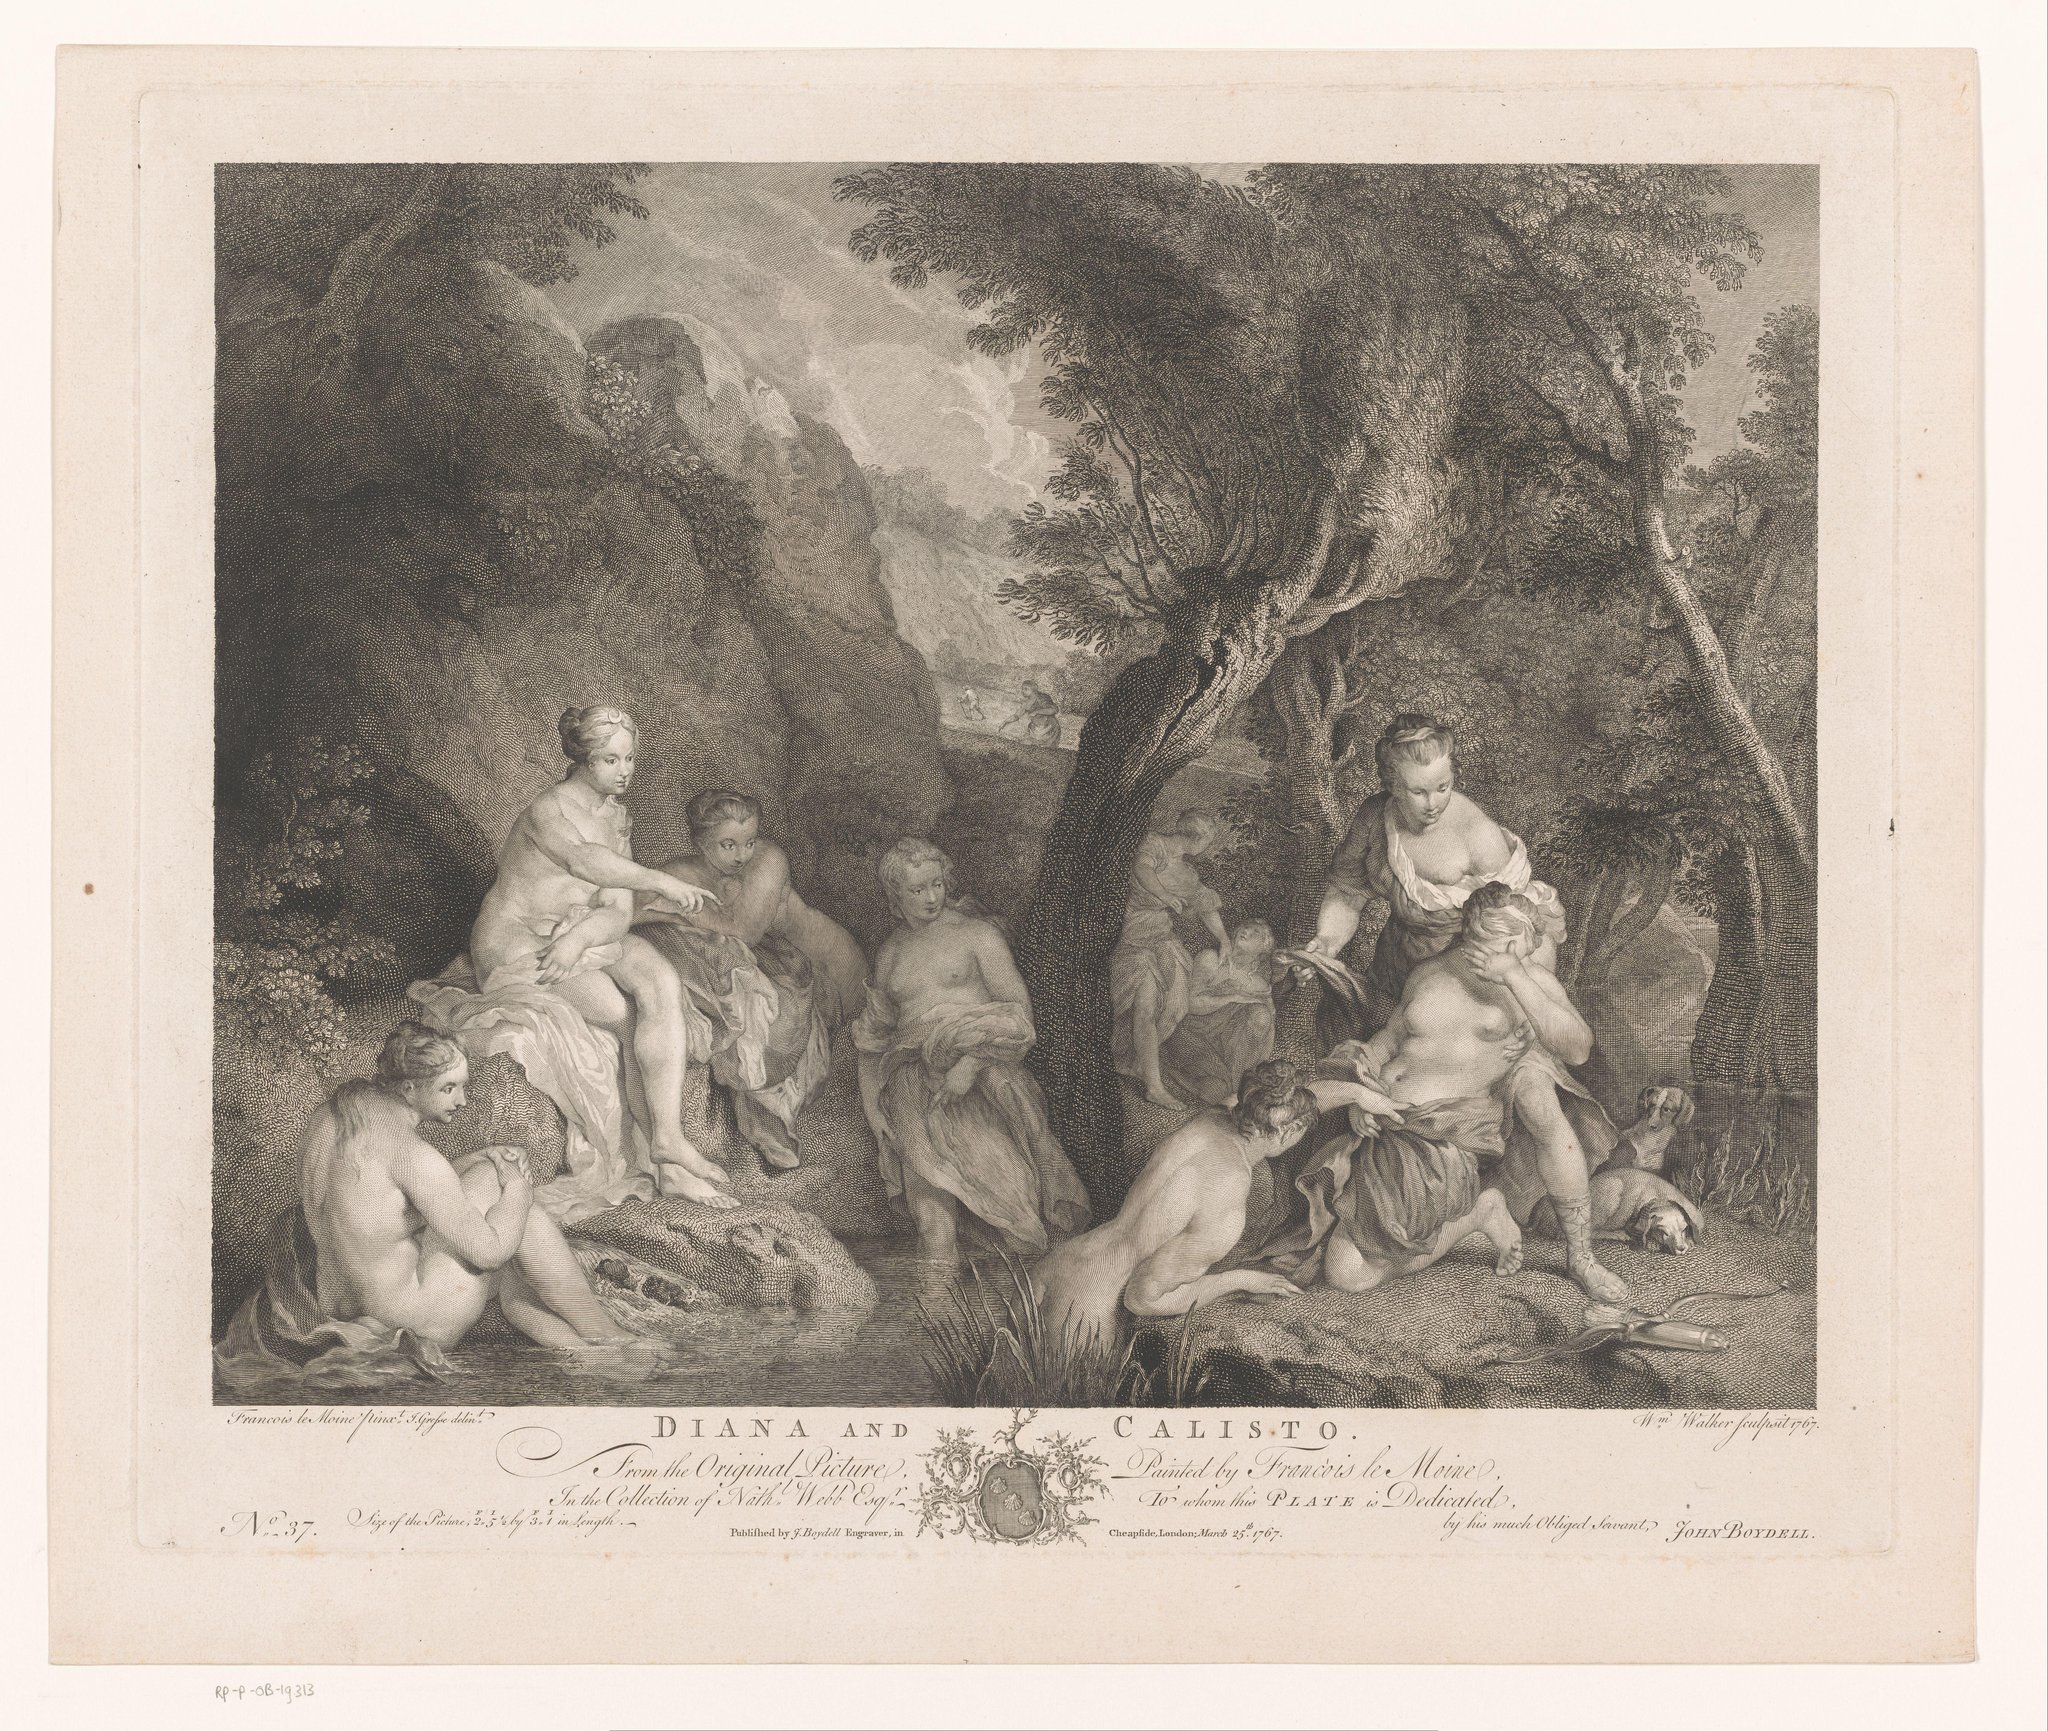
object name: print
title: Diana and Calisto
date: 1703-1767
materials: paper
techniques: etching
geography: london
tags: diana with her nymphs discovers the pregnancy of callisto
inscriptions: collector's mark: Lugt 2228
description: Prent hoort mogelijk bij de serie 'The Most Capital Paintings in England'.